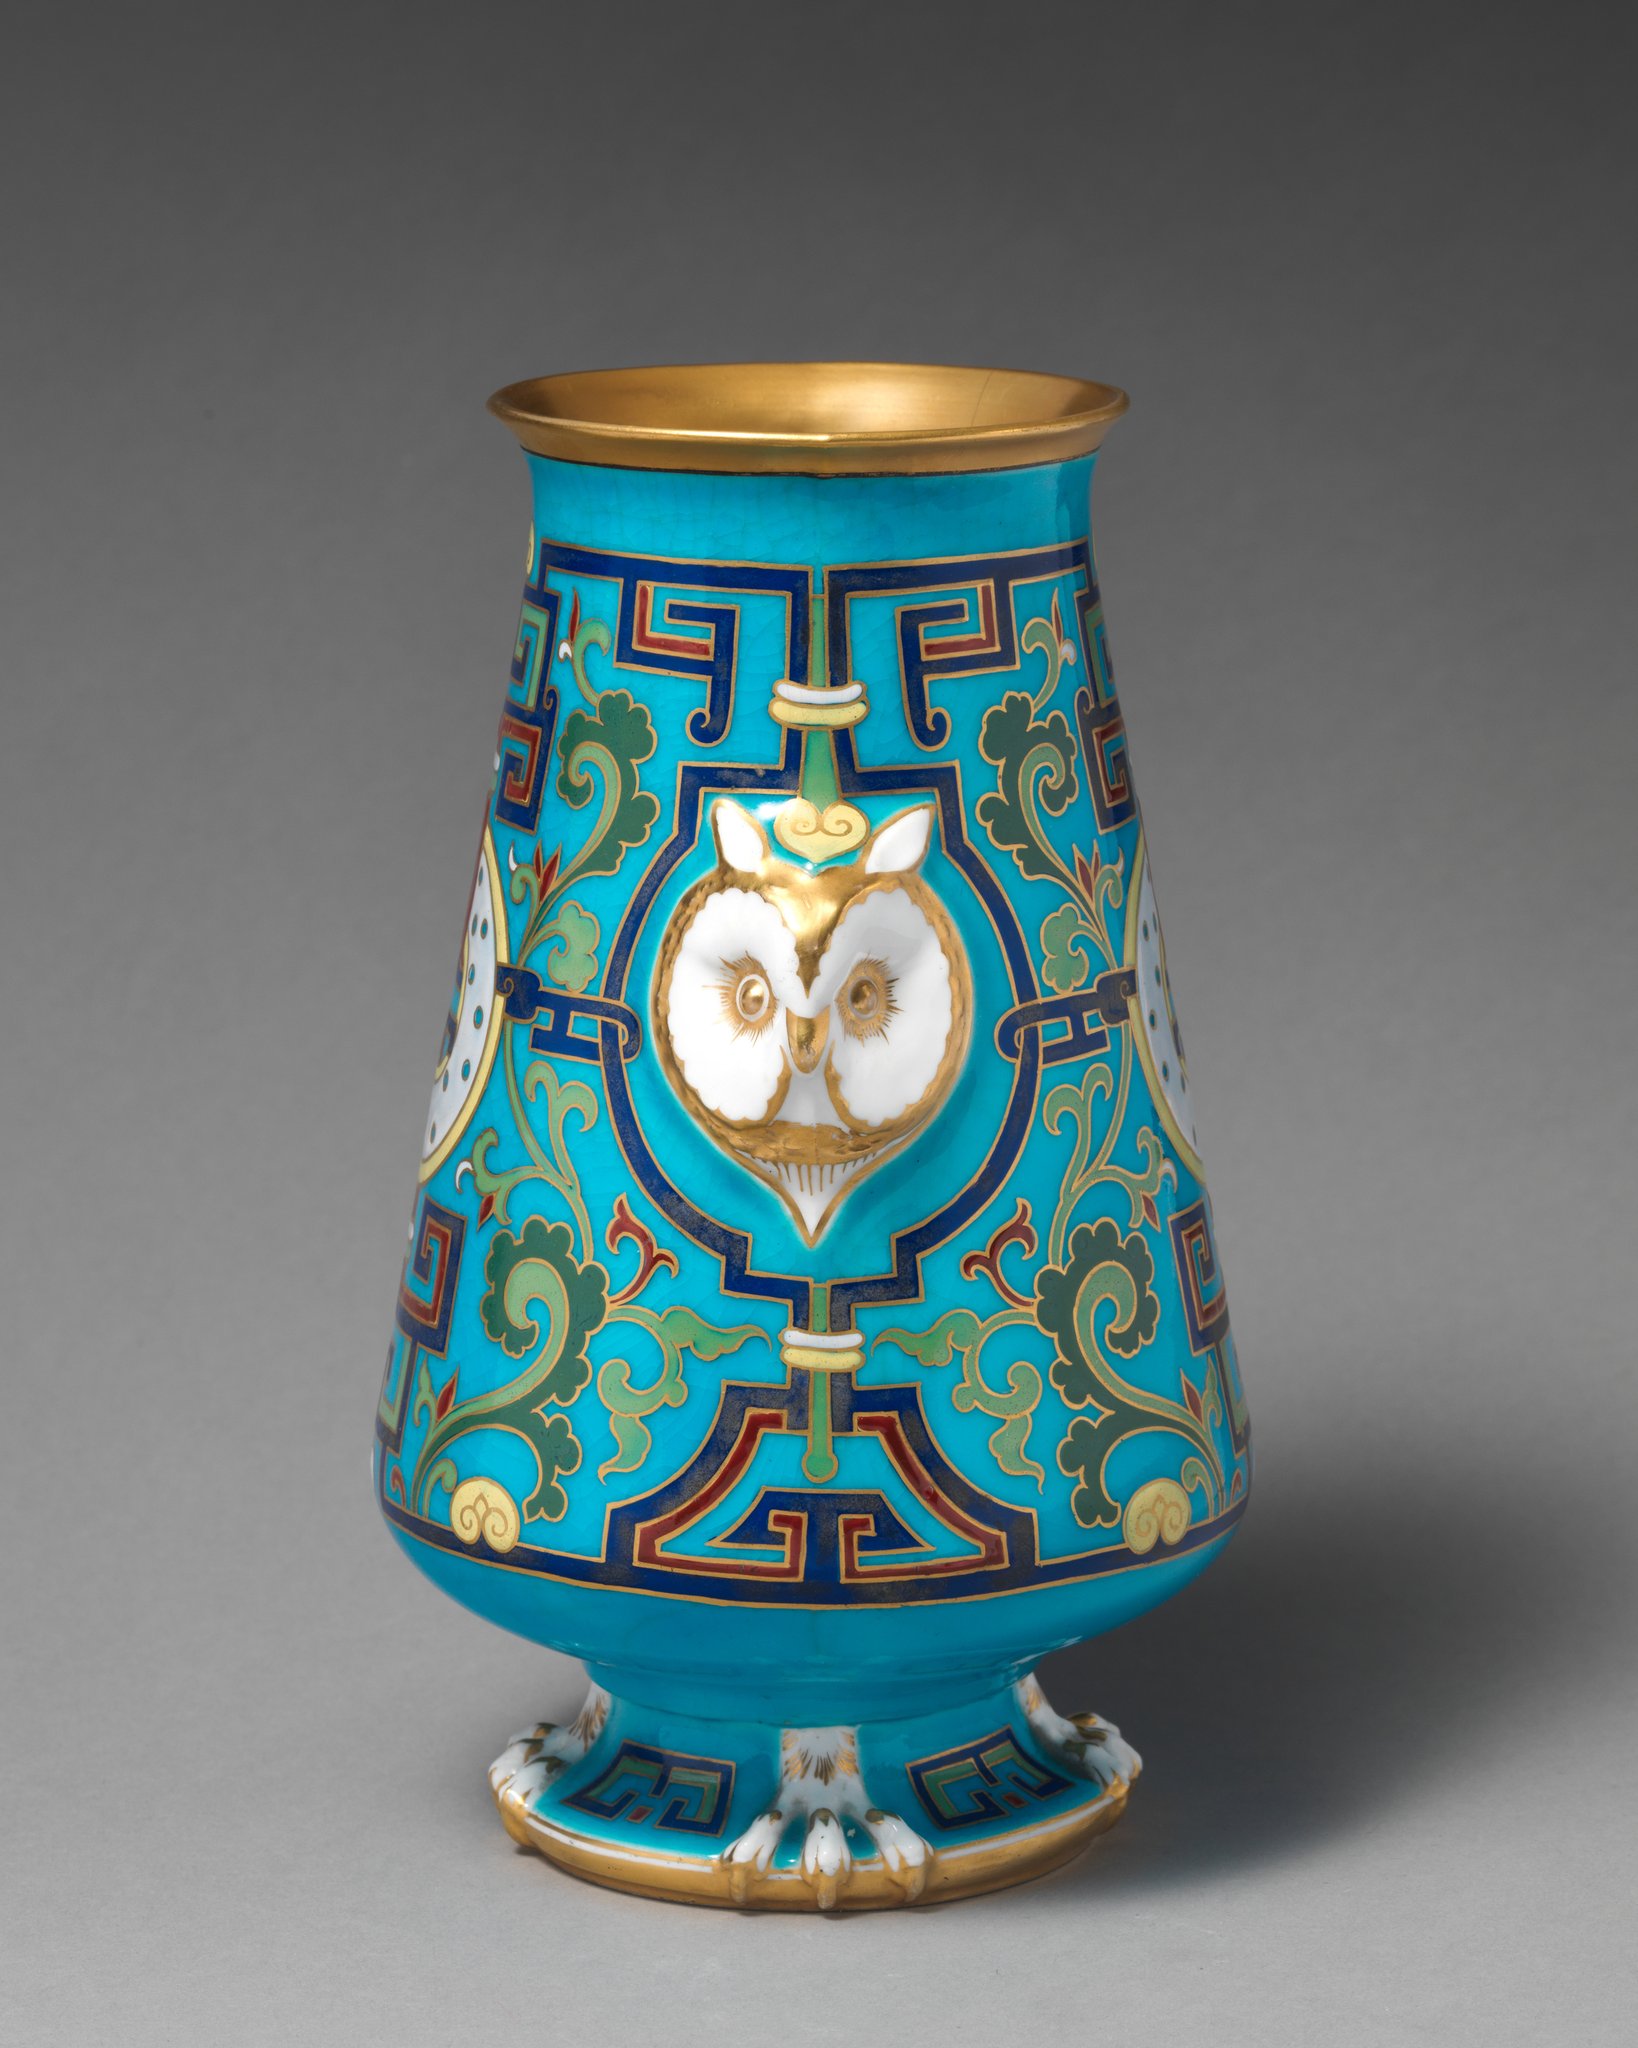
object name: vase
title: Vase with owl heads and "cloisonné" decoration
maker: minton(s)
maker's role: maker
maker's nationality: british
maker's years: 1793-2001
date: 1868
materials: bone china